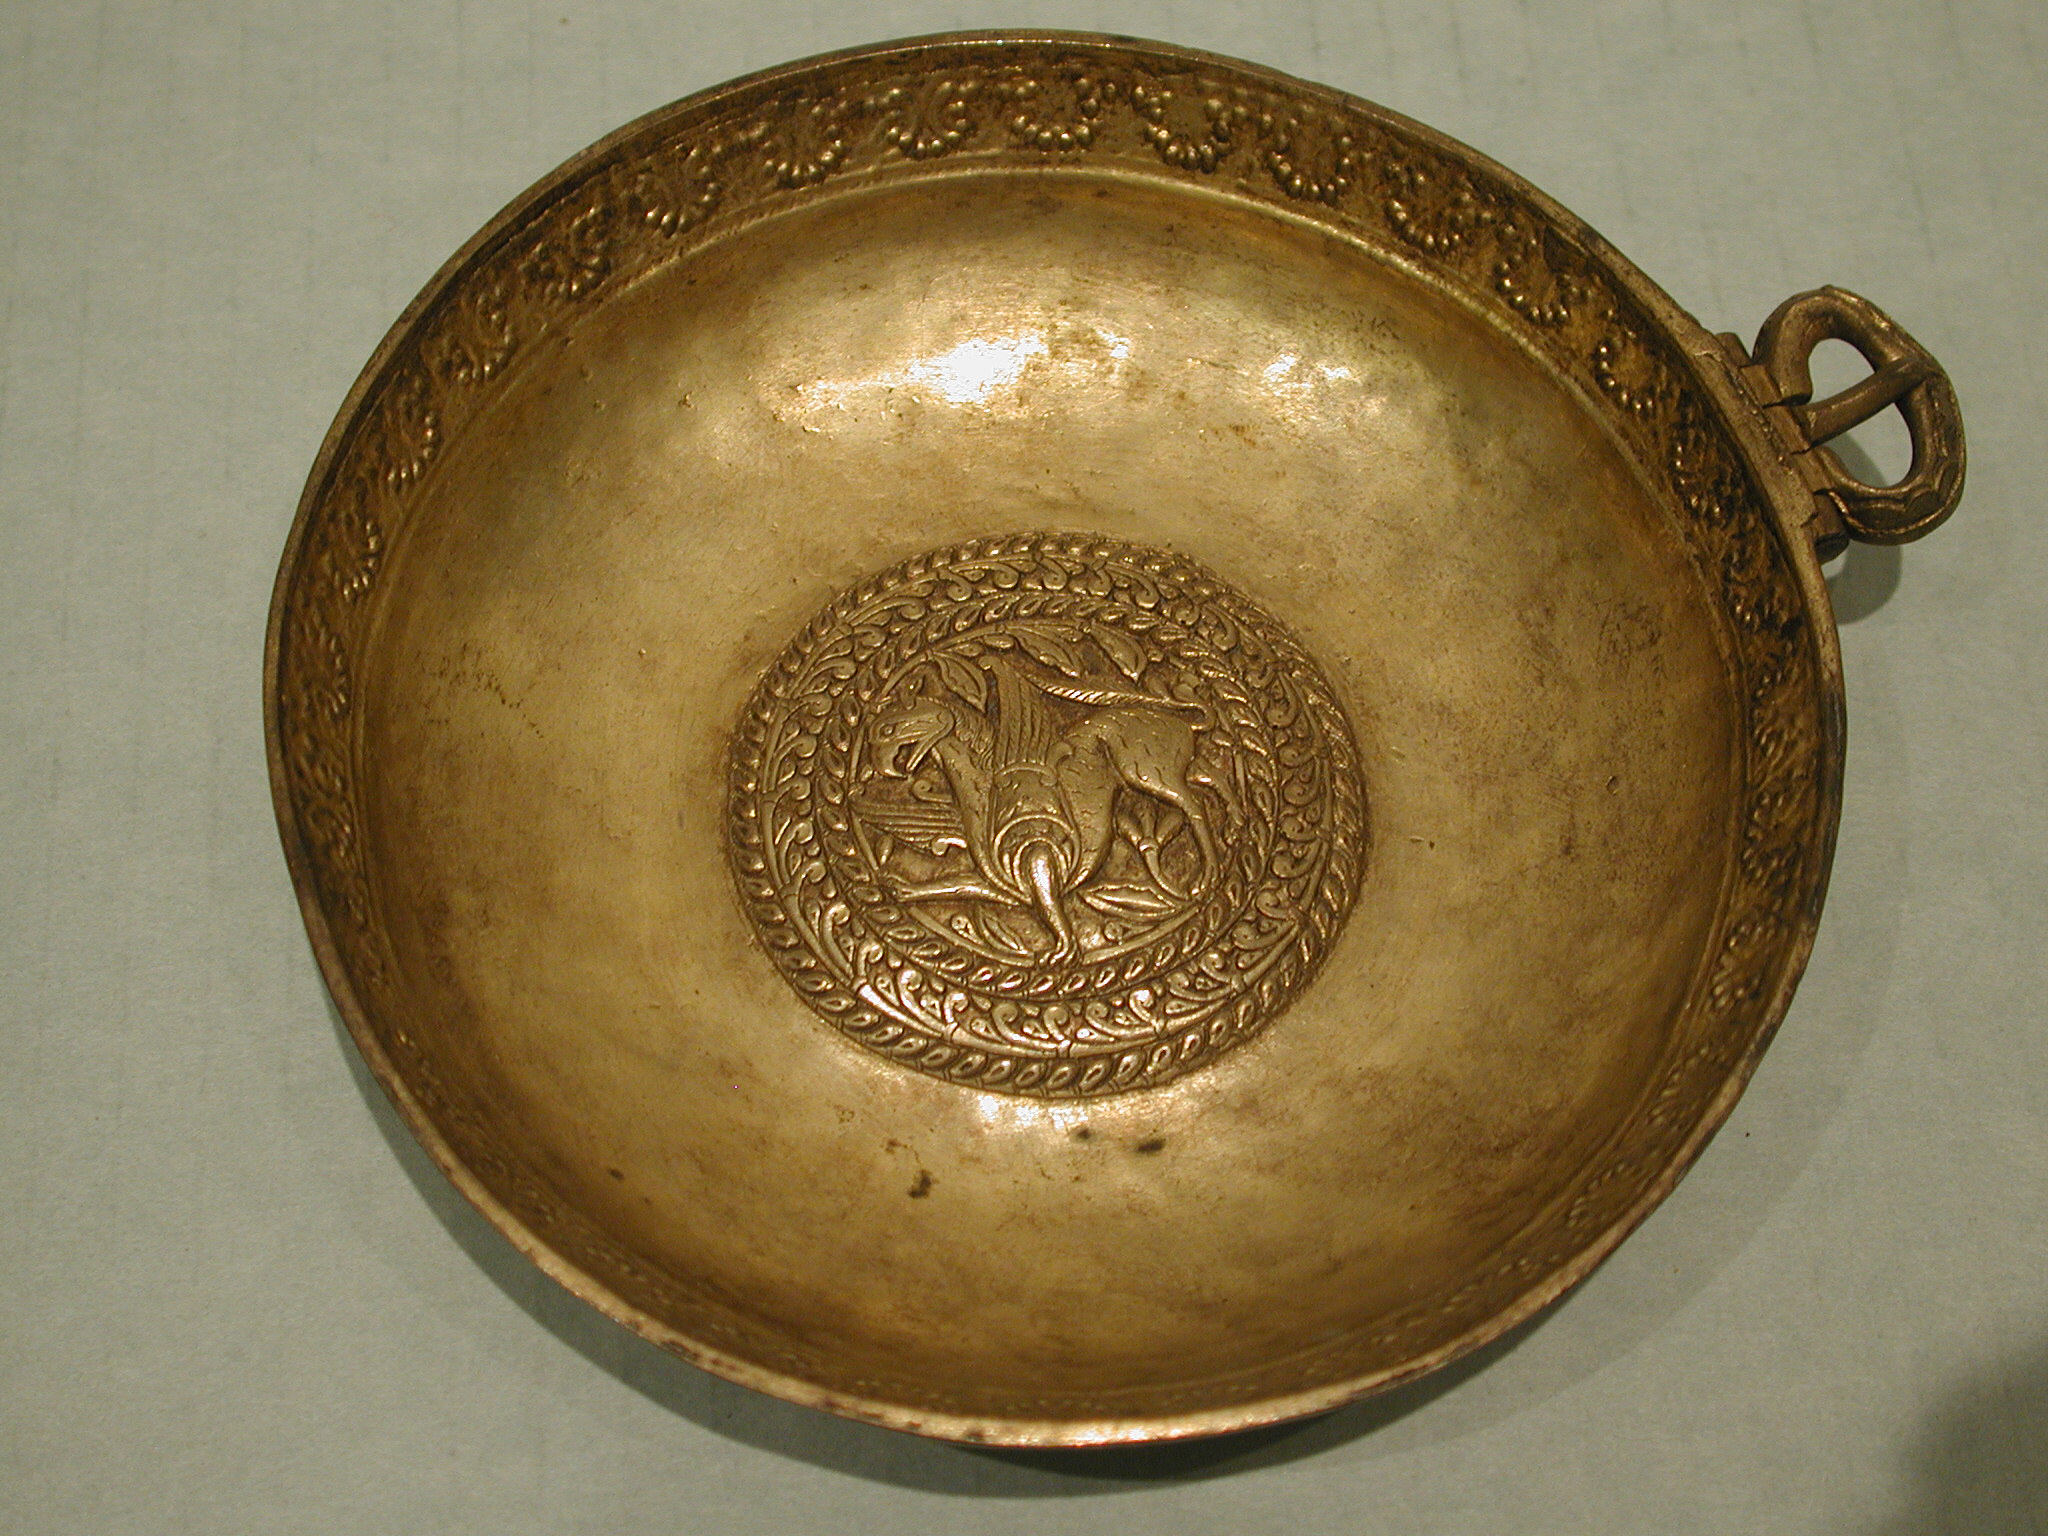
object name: bowl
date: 1801-1900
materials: metal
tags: griffins